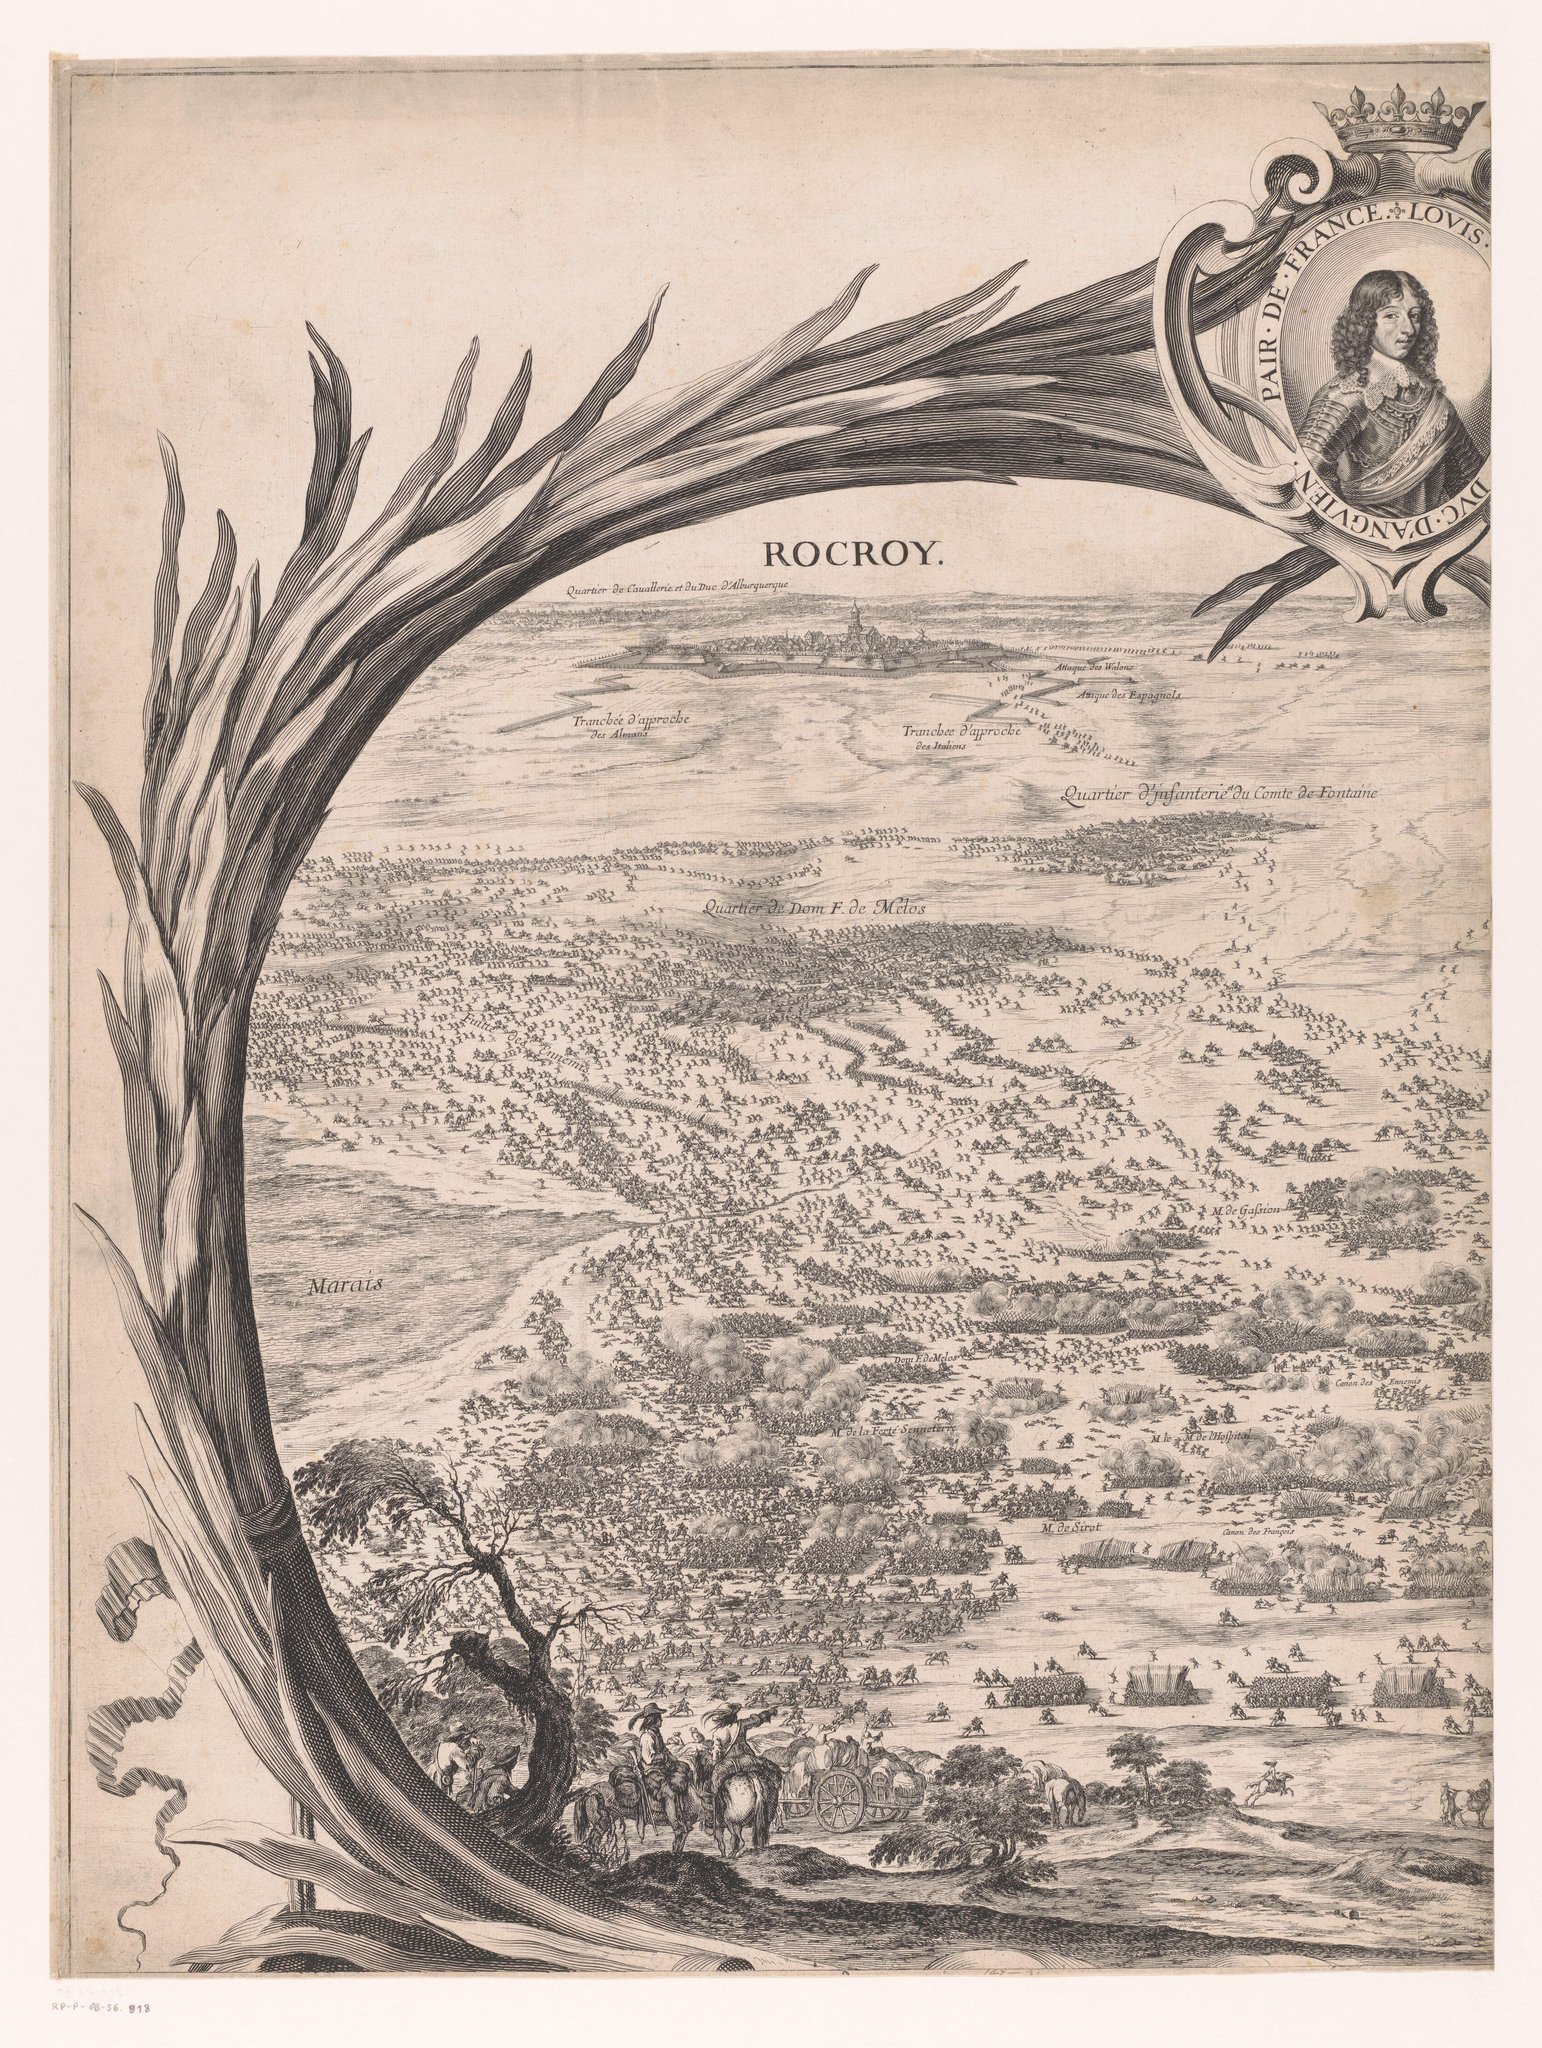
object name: print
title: Slag bij Rocroi (linkerdeel)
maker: nicolas cochin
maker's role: print maker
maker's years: 1610-1686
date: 1643-1686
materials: paper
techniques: engraving, etching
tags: battle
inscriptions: collector's mark: Lugt 240